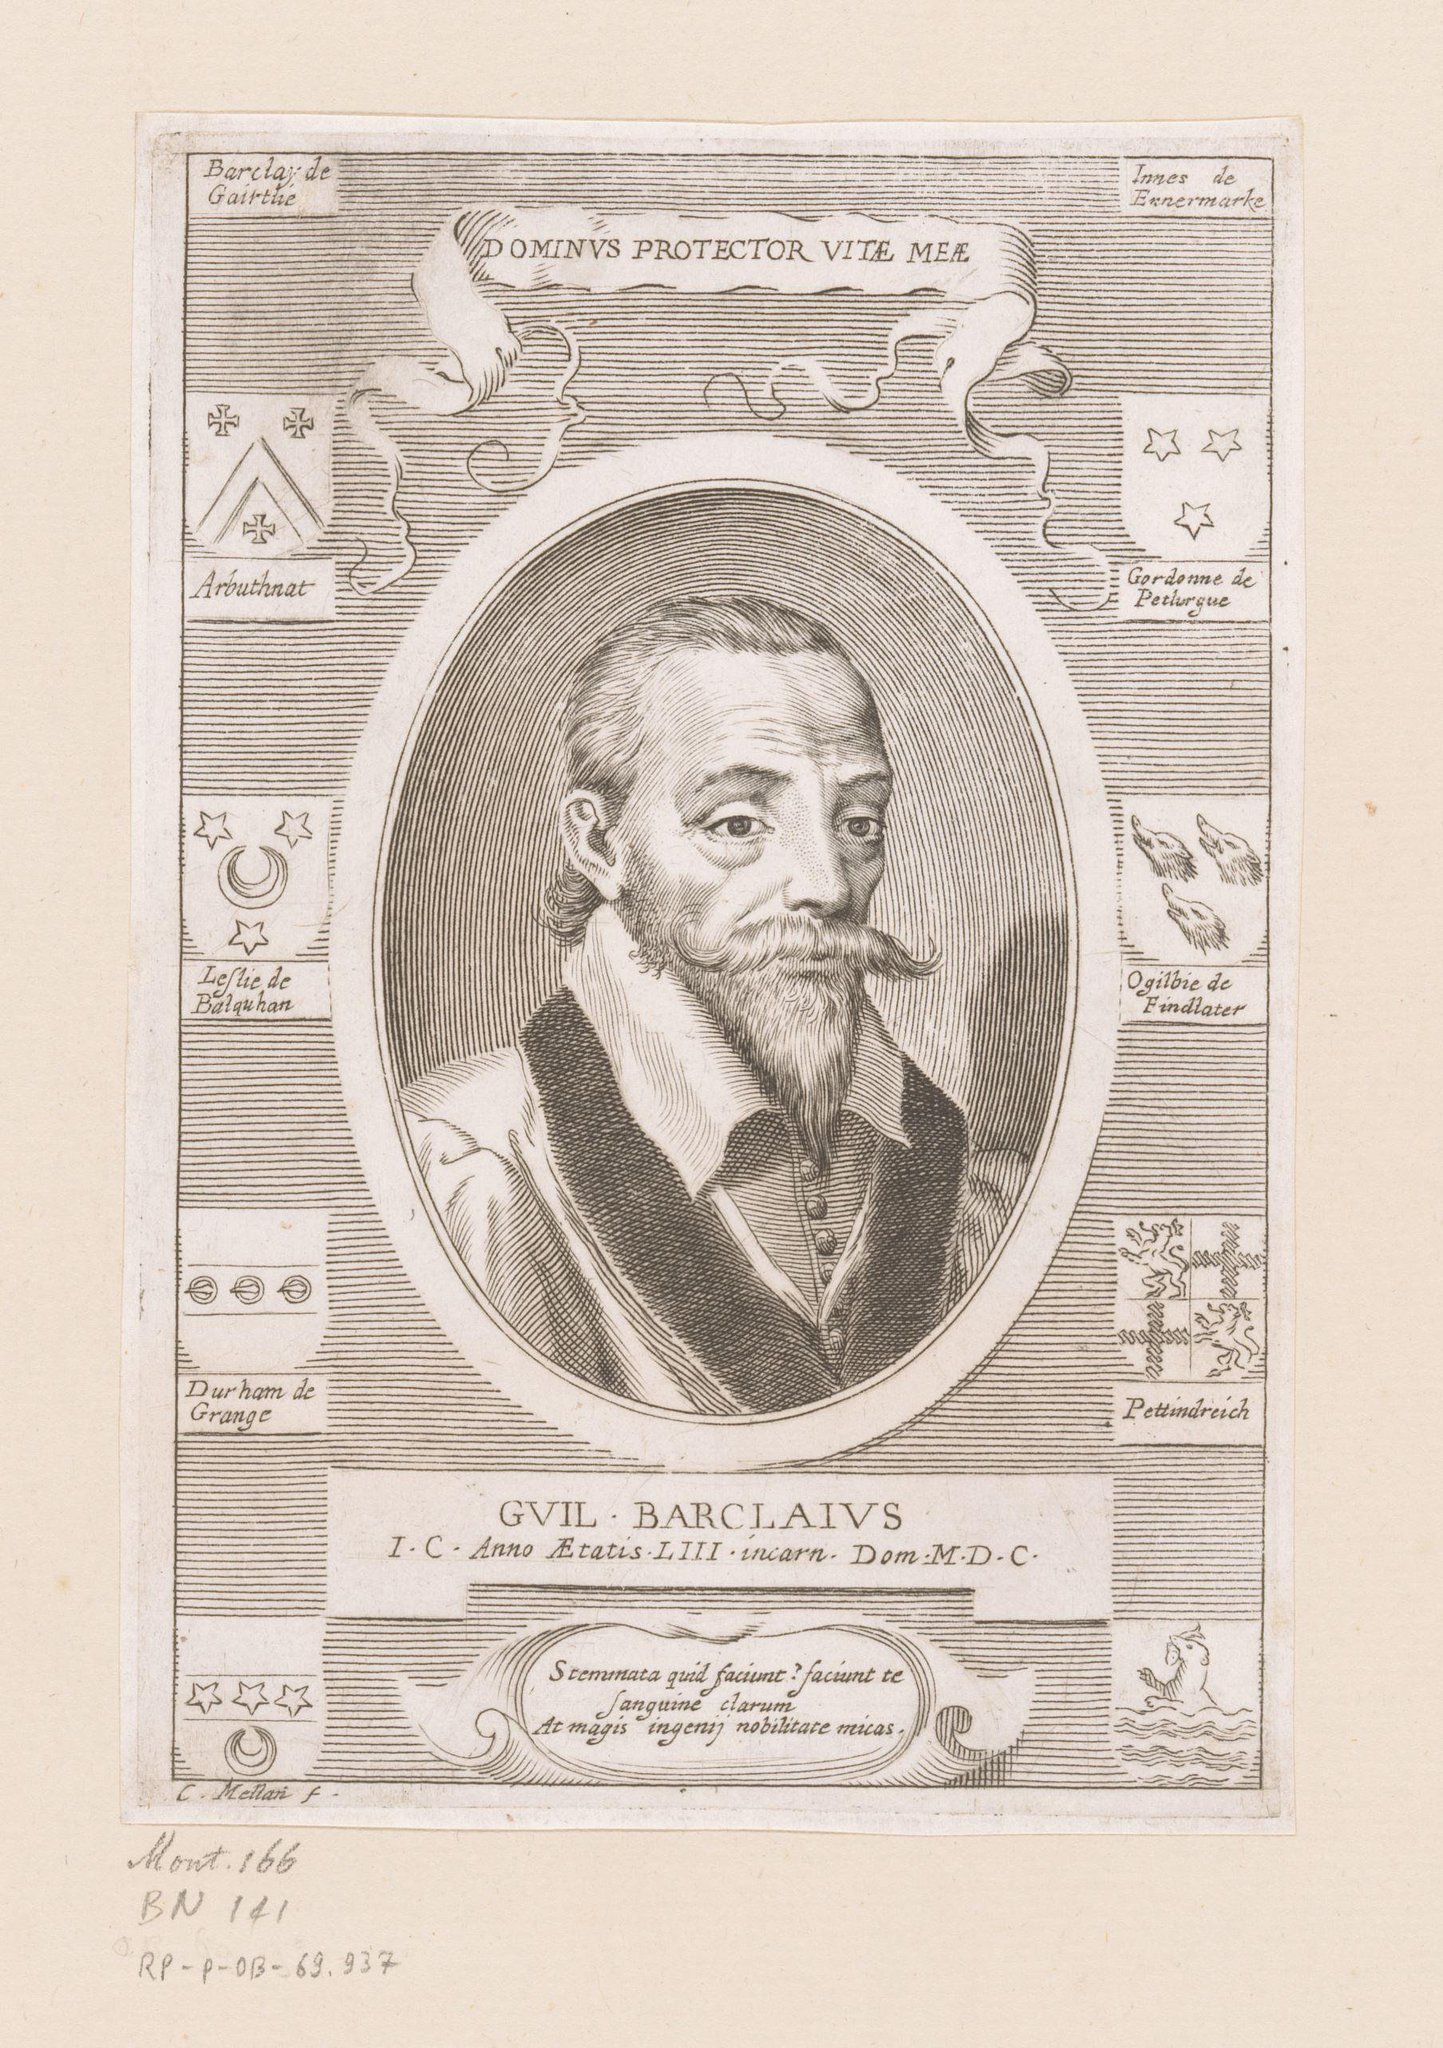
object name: print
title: Portret van Guillaume Barclay op 53-jarige leeftijd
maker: claude mellan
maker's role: draughtsman, print maker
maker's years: 1598-1688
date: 1619-1624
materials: paper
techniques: engraving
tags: william barclay, historical persons, armorial bearing, heraldry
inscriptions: collector's mark: Lugt 240